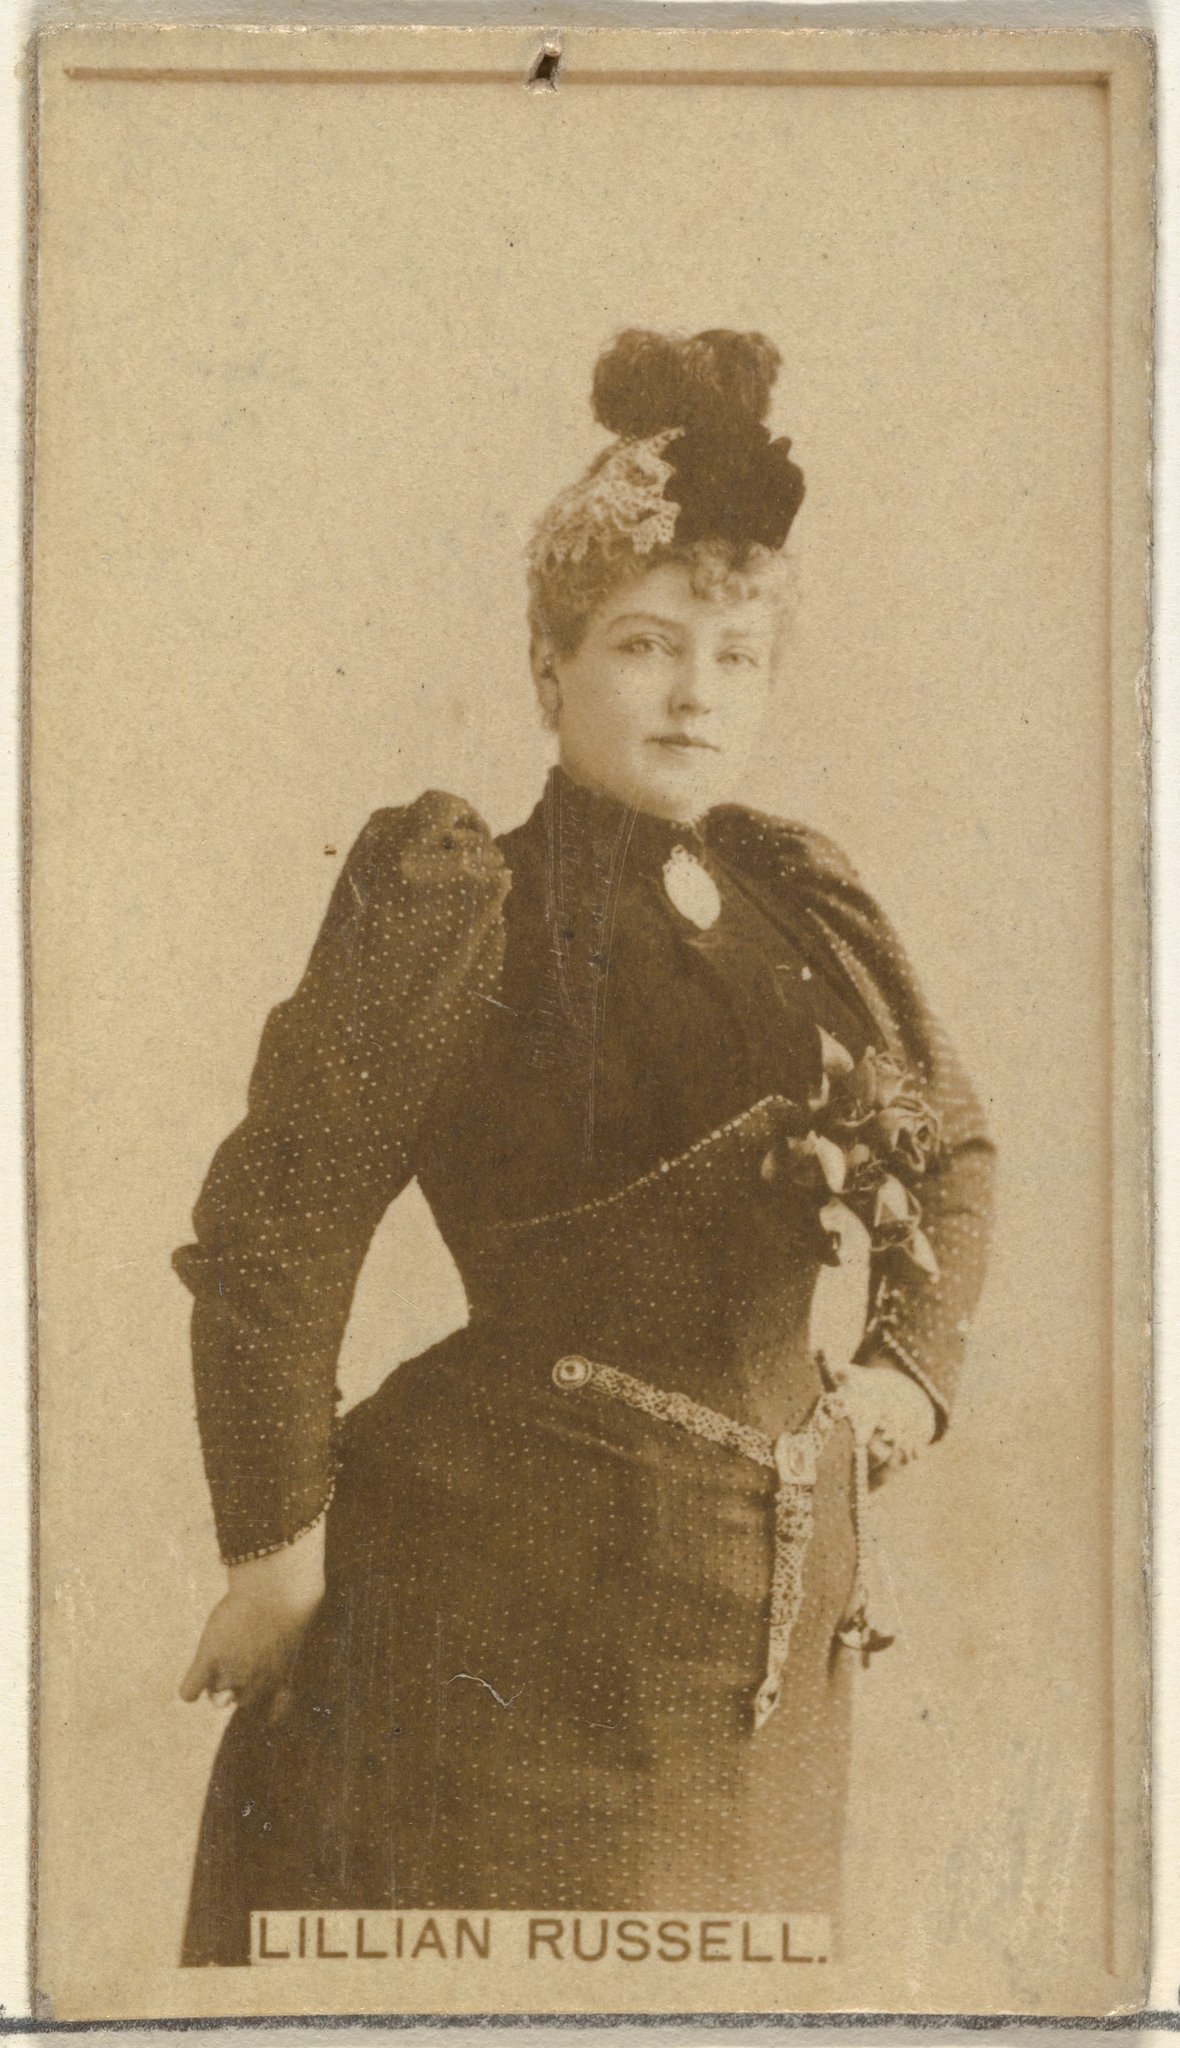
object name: photograph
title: Lillian Russell, from the Actors and Actresses series (N145-8) issued by Duke Sons & Co. to promote Duke Cigarettes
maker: w. duke, sons & co.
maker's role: publisher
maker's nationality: american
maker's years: 1870-1920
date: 1891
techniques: albumen silver print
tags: portraits,women,actresses